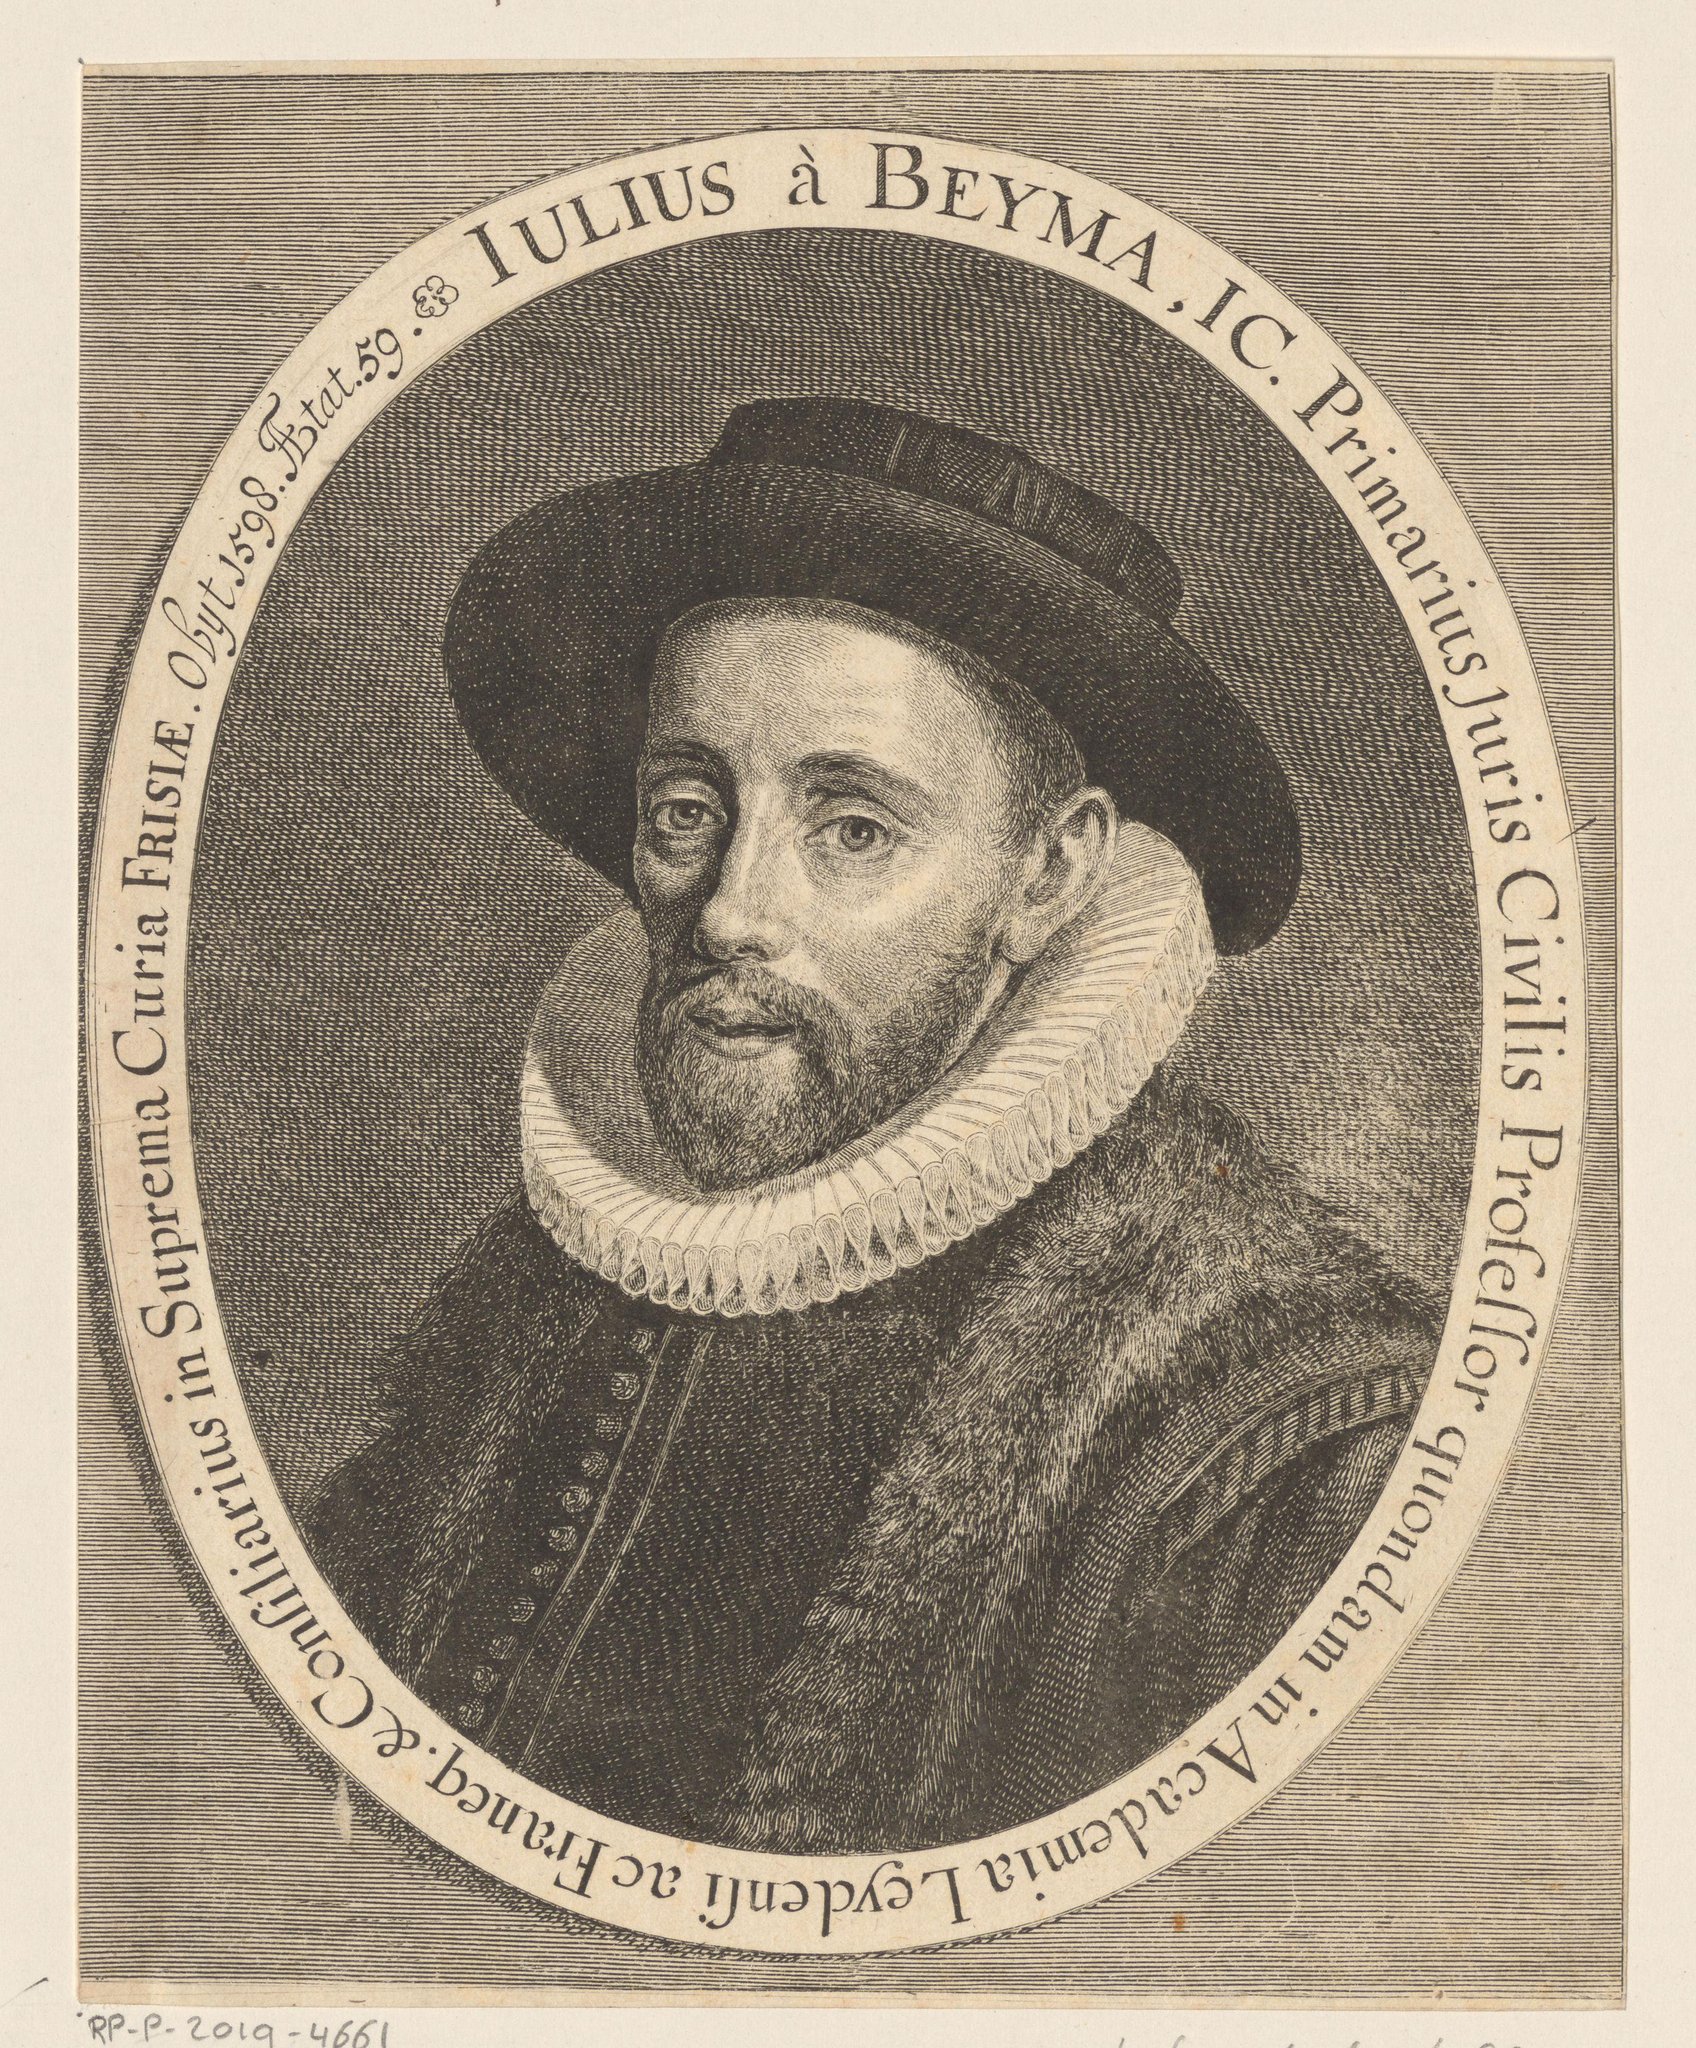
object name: print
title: Portret van Julius van Beyma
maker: jonas suyderhoef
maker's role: draughtsman, print maker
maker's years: 1613-1686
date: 1623-1686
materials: paper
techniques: engraving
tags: historical persons